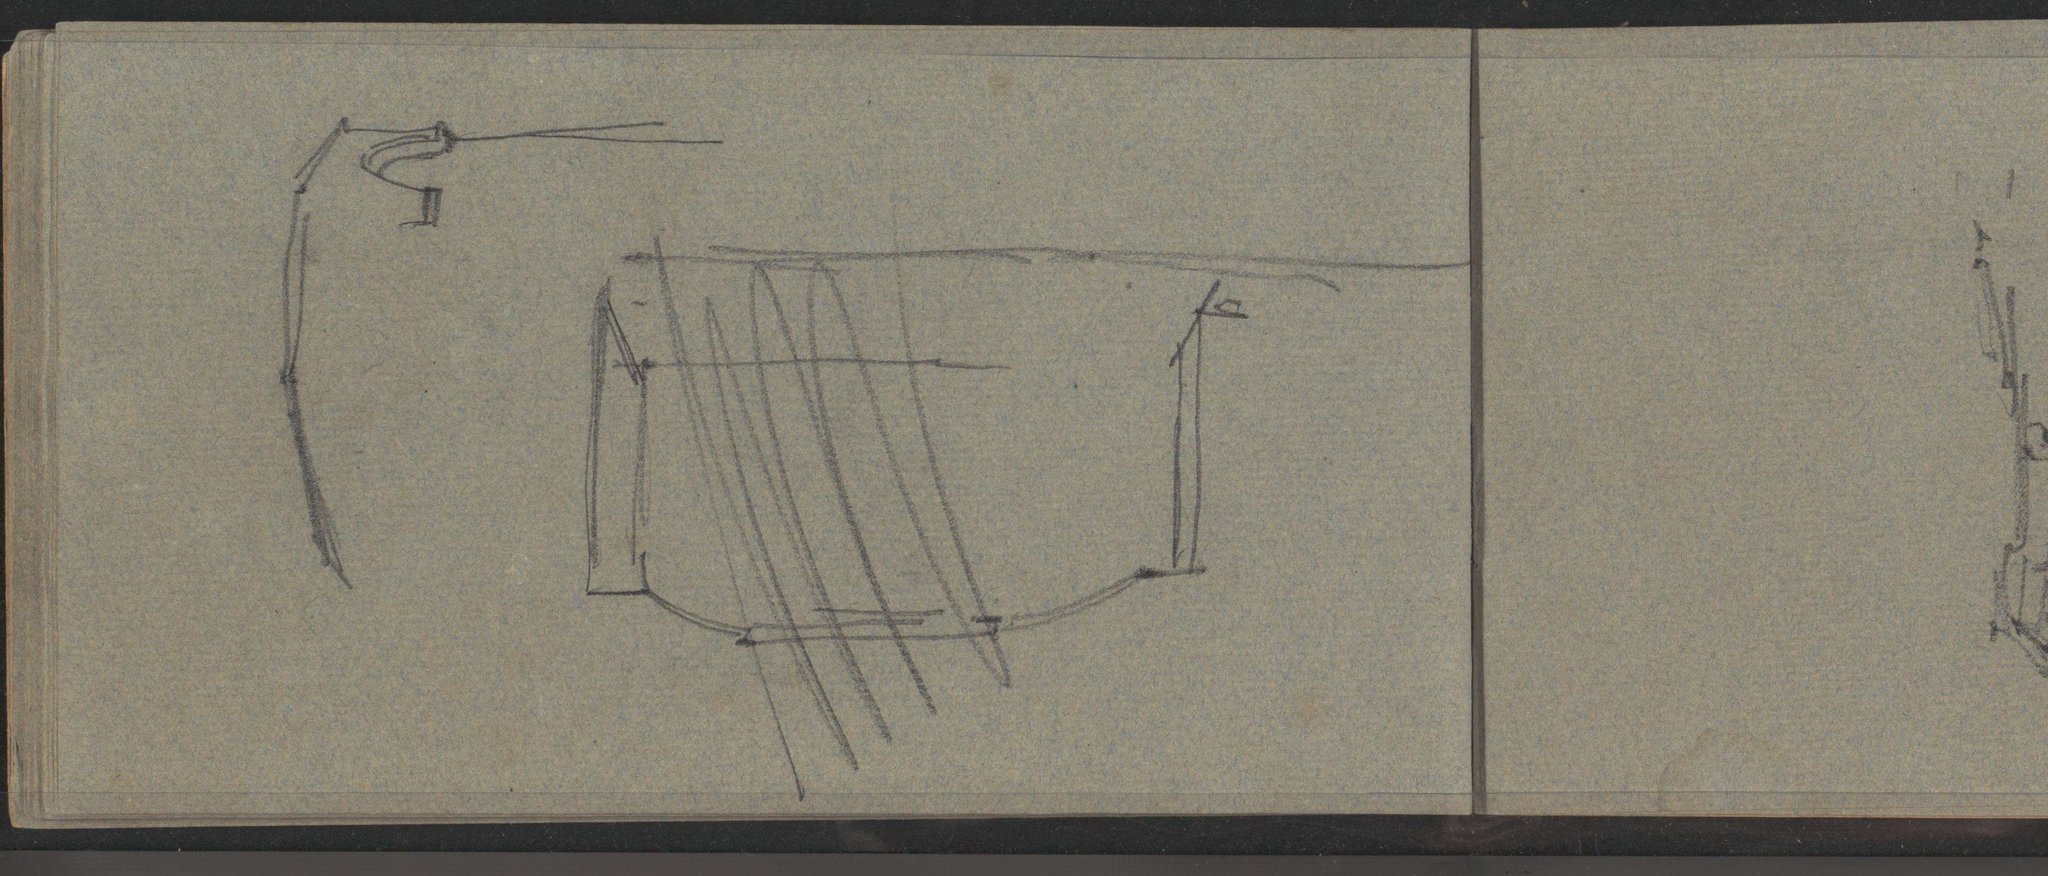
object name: sketchbook leaf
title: Toren van het landgoed Torenzicht te Poeldijk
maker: george hendrik breitner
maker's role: draughtsman, painter, print maker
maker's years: 1857-1923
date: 1883-1885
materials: paper, pencil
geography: the hague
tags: tower (of house or building)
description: Blad 9 verso uit een schetsboek met 36 bladen.